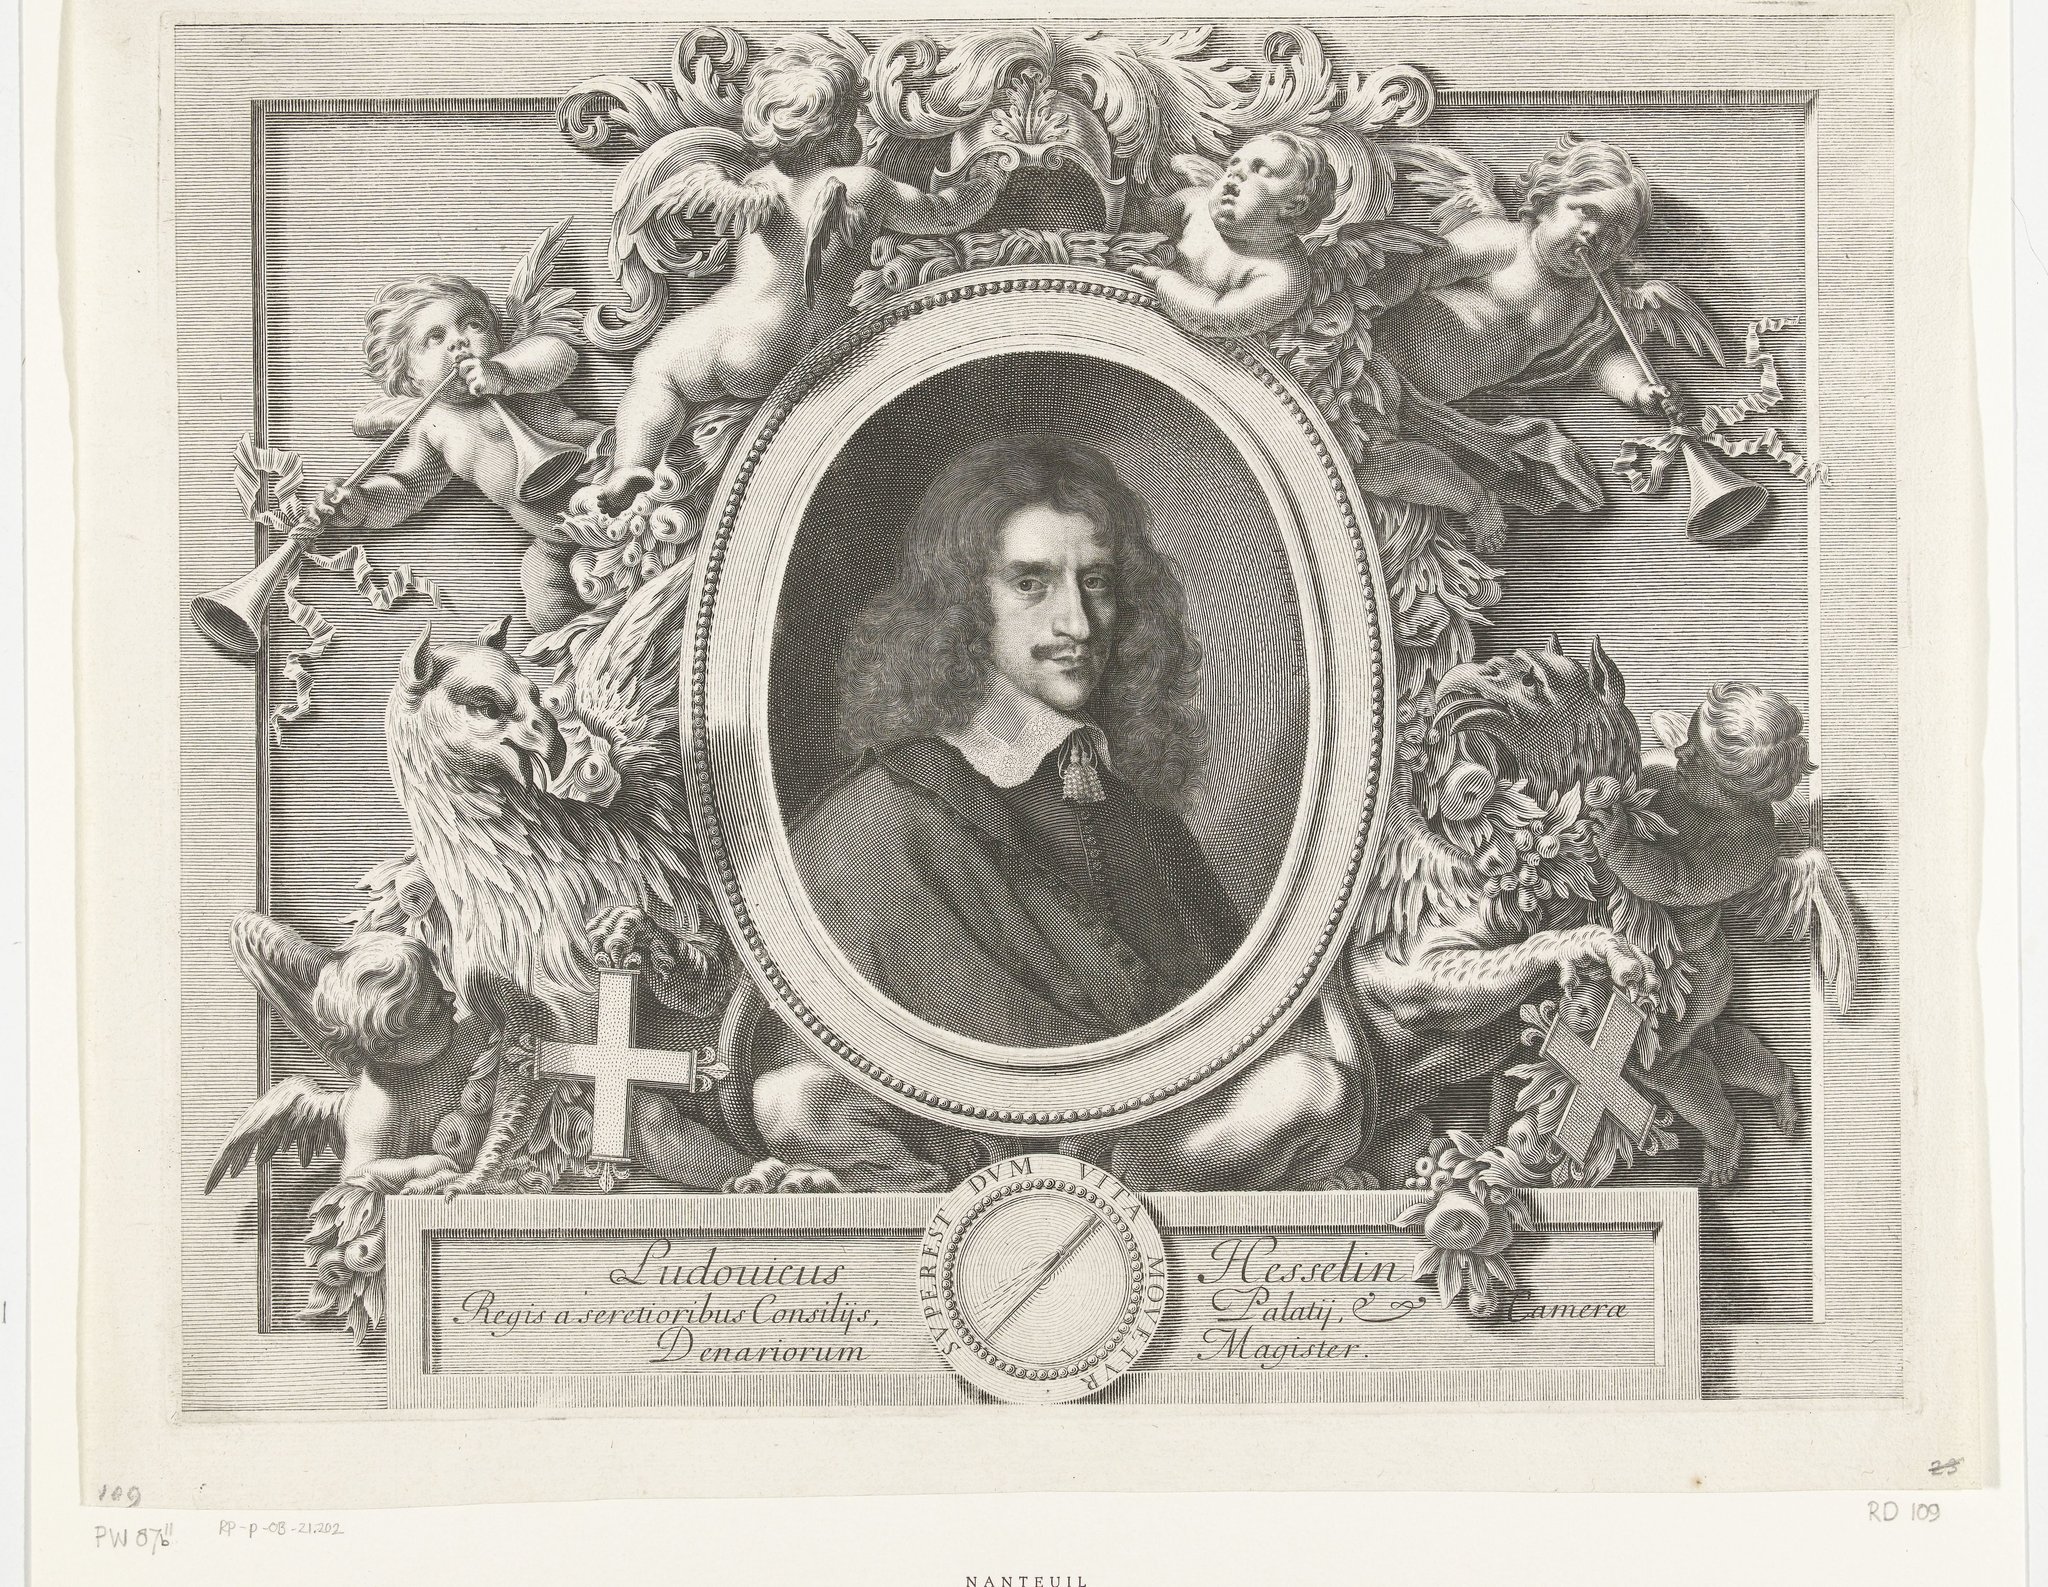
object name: print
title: Portret van Louis Hesselin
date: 1650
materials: paper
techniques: engraving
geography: france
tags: louis hesselin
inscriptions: collector's mark: Lugt 2228, collector's mark: Lugt 240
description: Portret van de staatsadviseur Louis Hesselin, in een ovale omlijsting, omgeven door bladranken met vruchten, zes putti en aan weerzijde een griffioen. Onderaan een tablet met een drieregelige tekst, in het midden daarvan een vuurpijl en het motto: superest dum vita moventur. Gedrukt van twee platen.